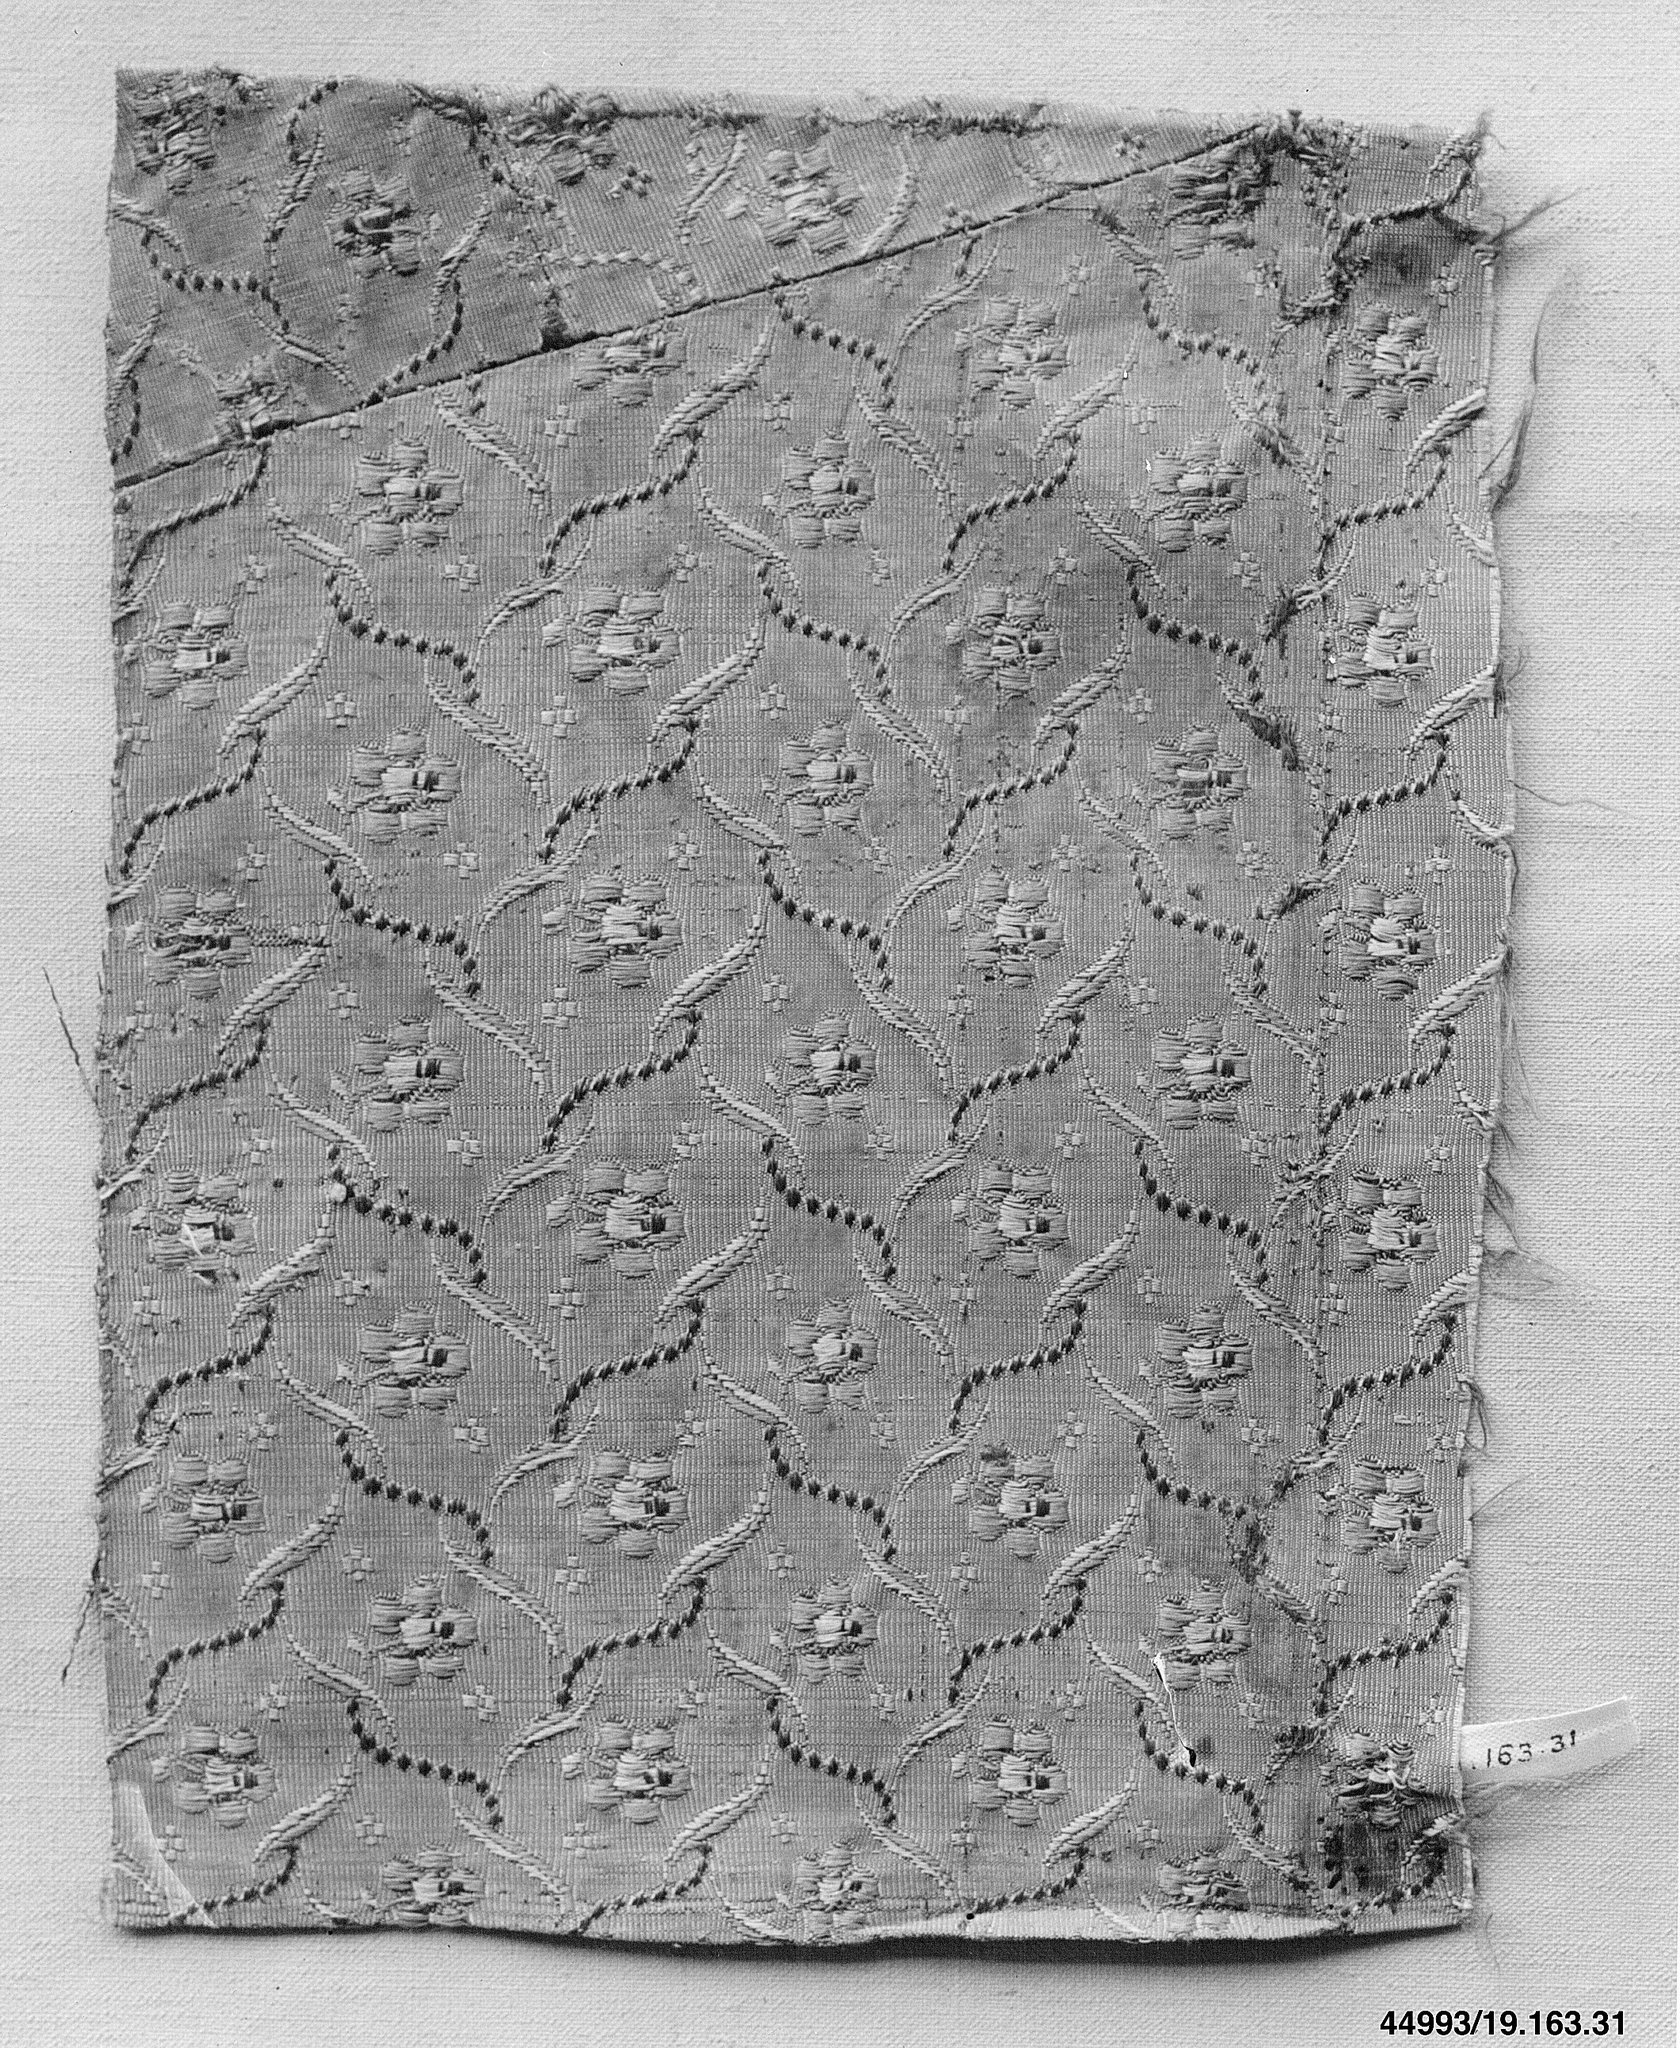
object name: fragment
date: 1701-1800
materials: silk